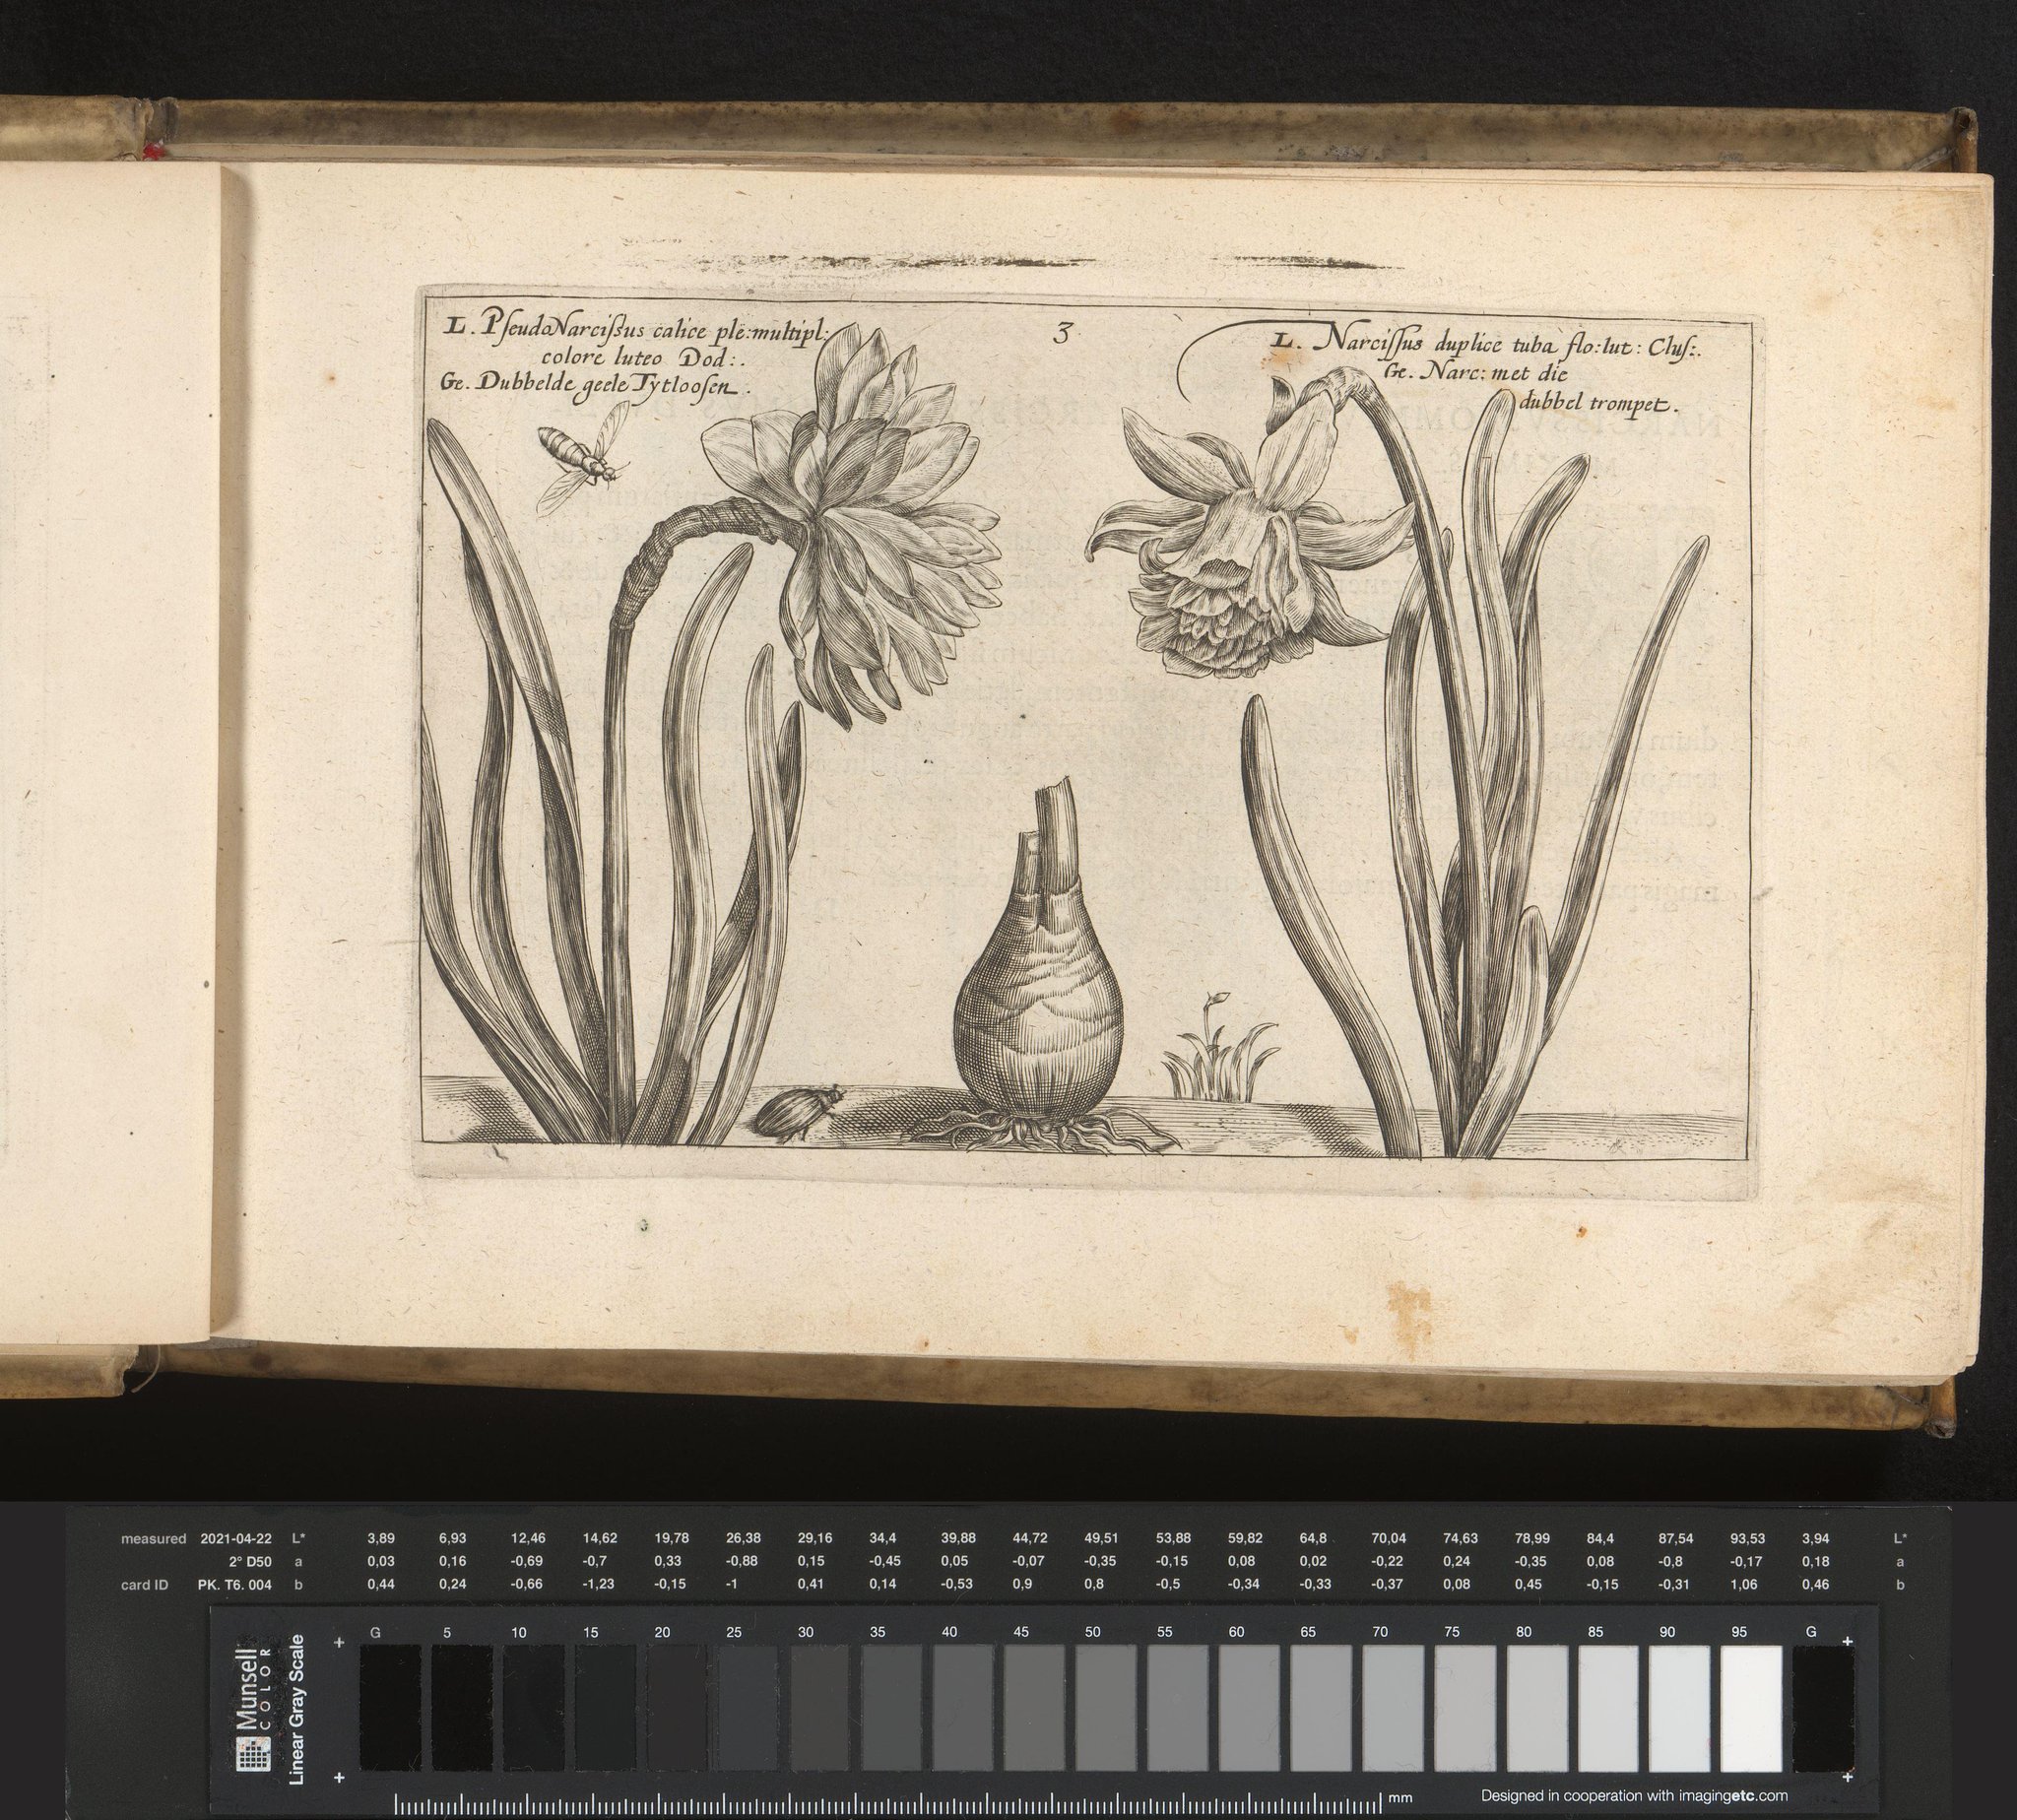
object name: print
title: Hortus floridus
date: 1617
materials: paper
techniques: engraving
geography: utrecht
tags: flowers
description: Prent uit: Passe, Crispijn van de (II). Hortus floridus in quo rariorum & minus vulgarium florum icones ad vivam veramque formam. Arnhem: Johannes Janssonius, 1617.